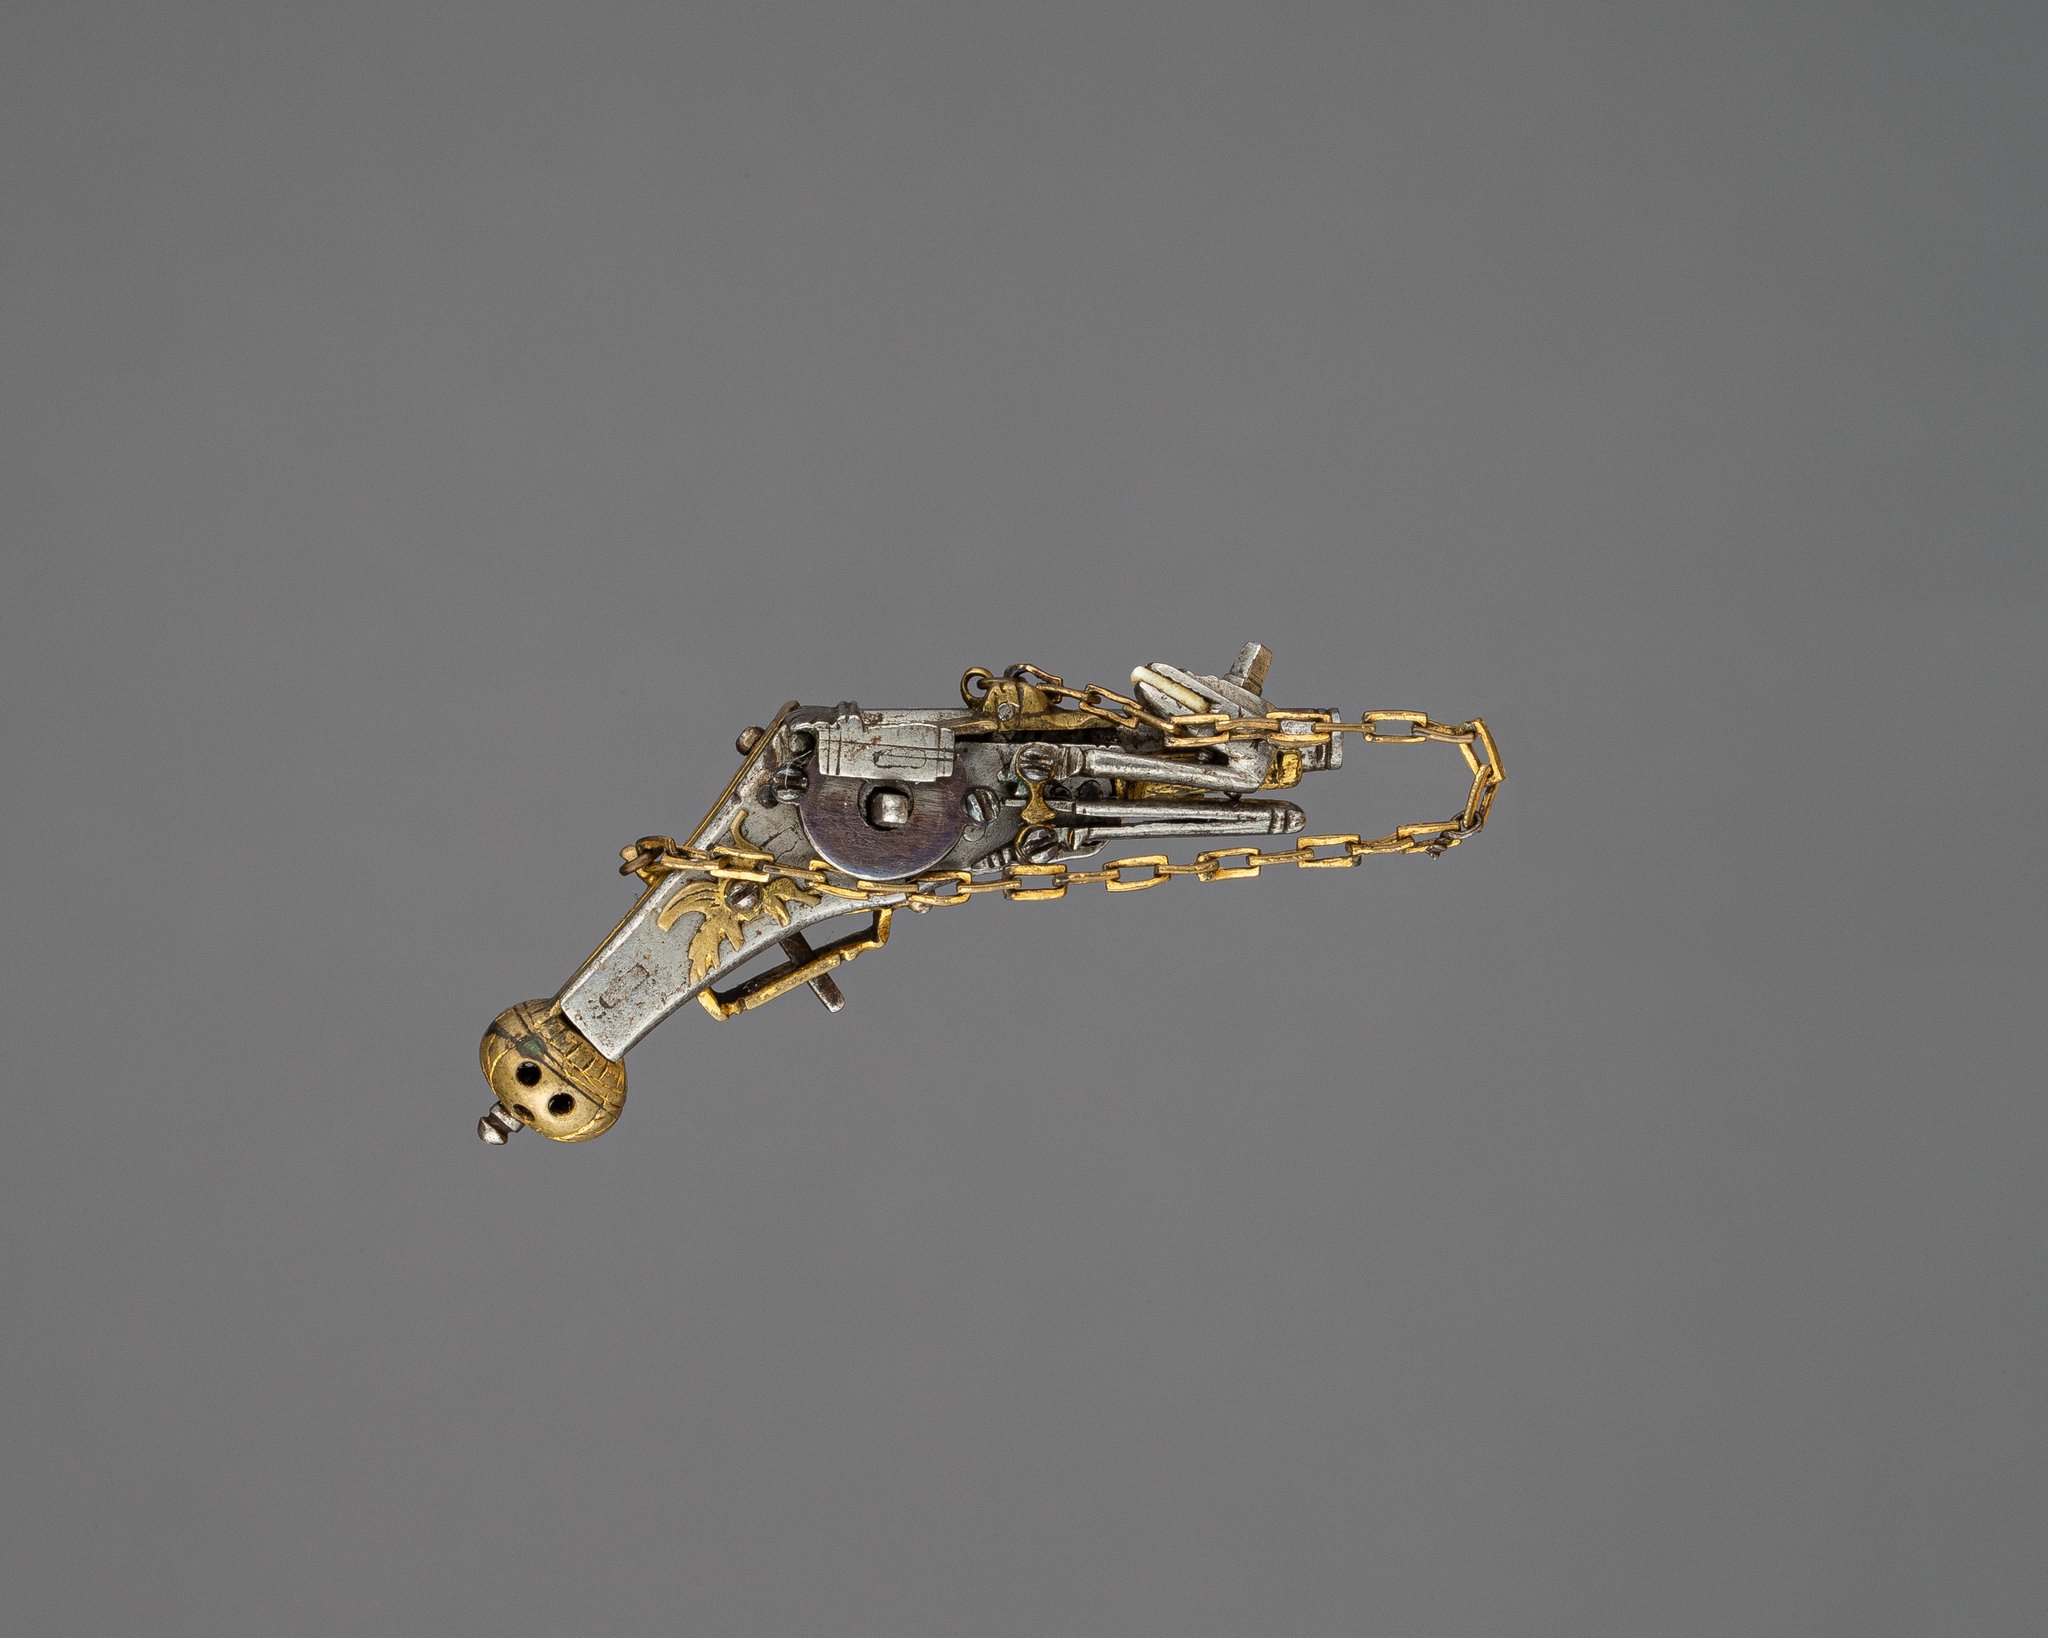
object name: pair of wheellock pistol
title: Model of Wheellock Pistol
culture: german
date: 1550-1600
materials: steel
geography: germany